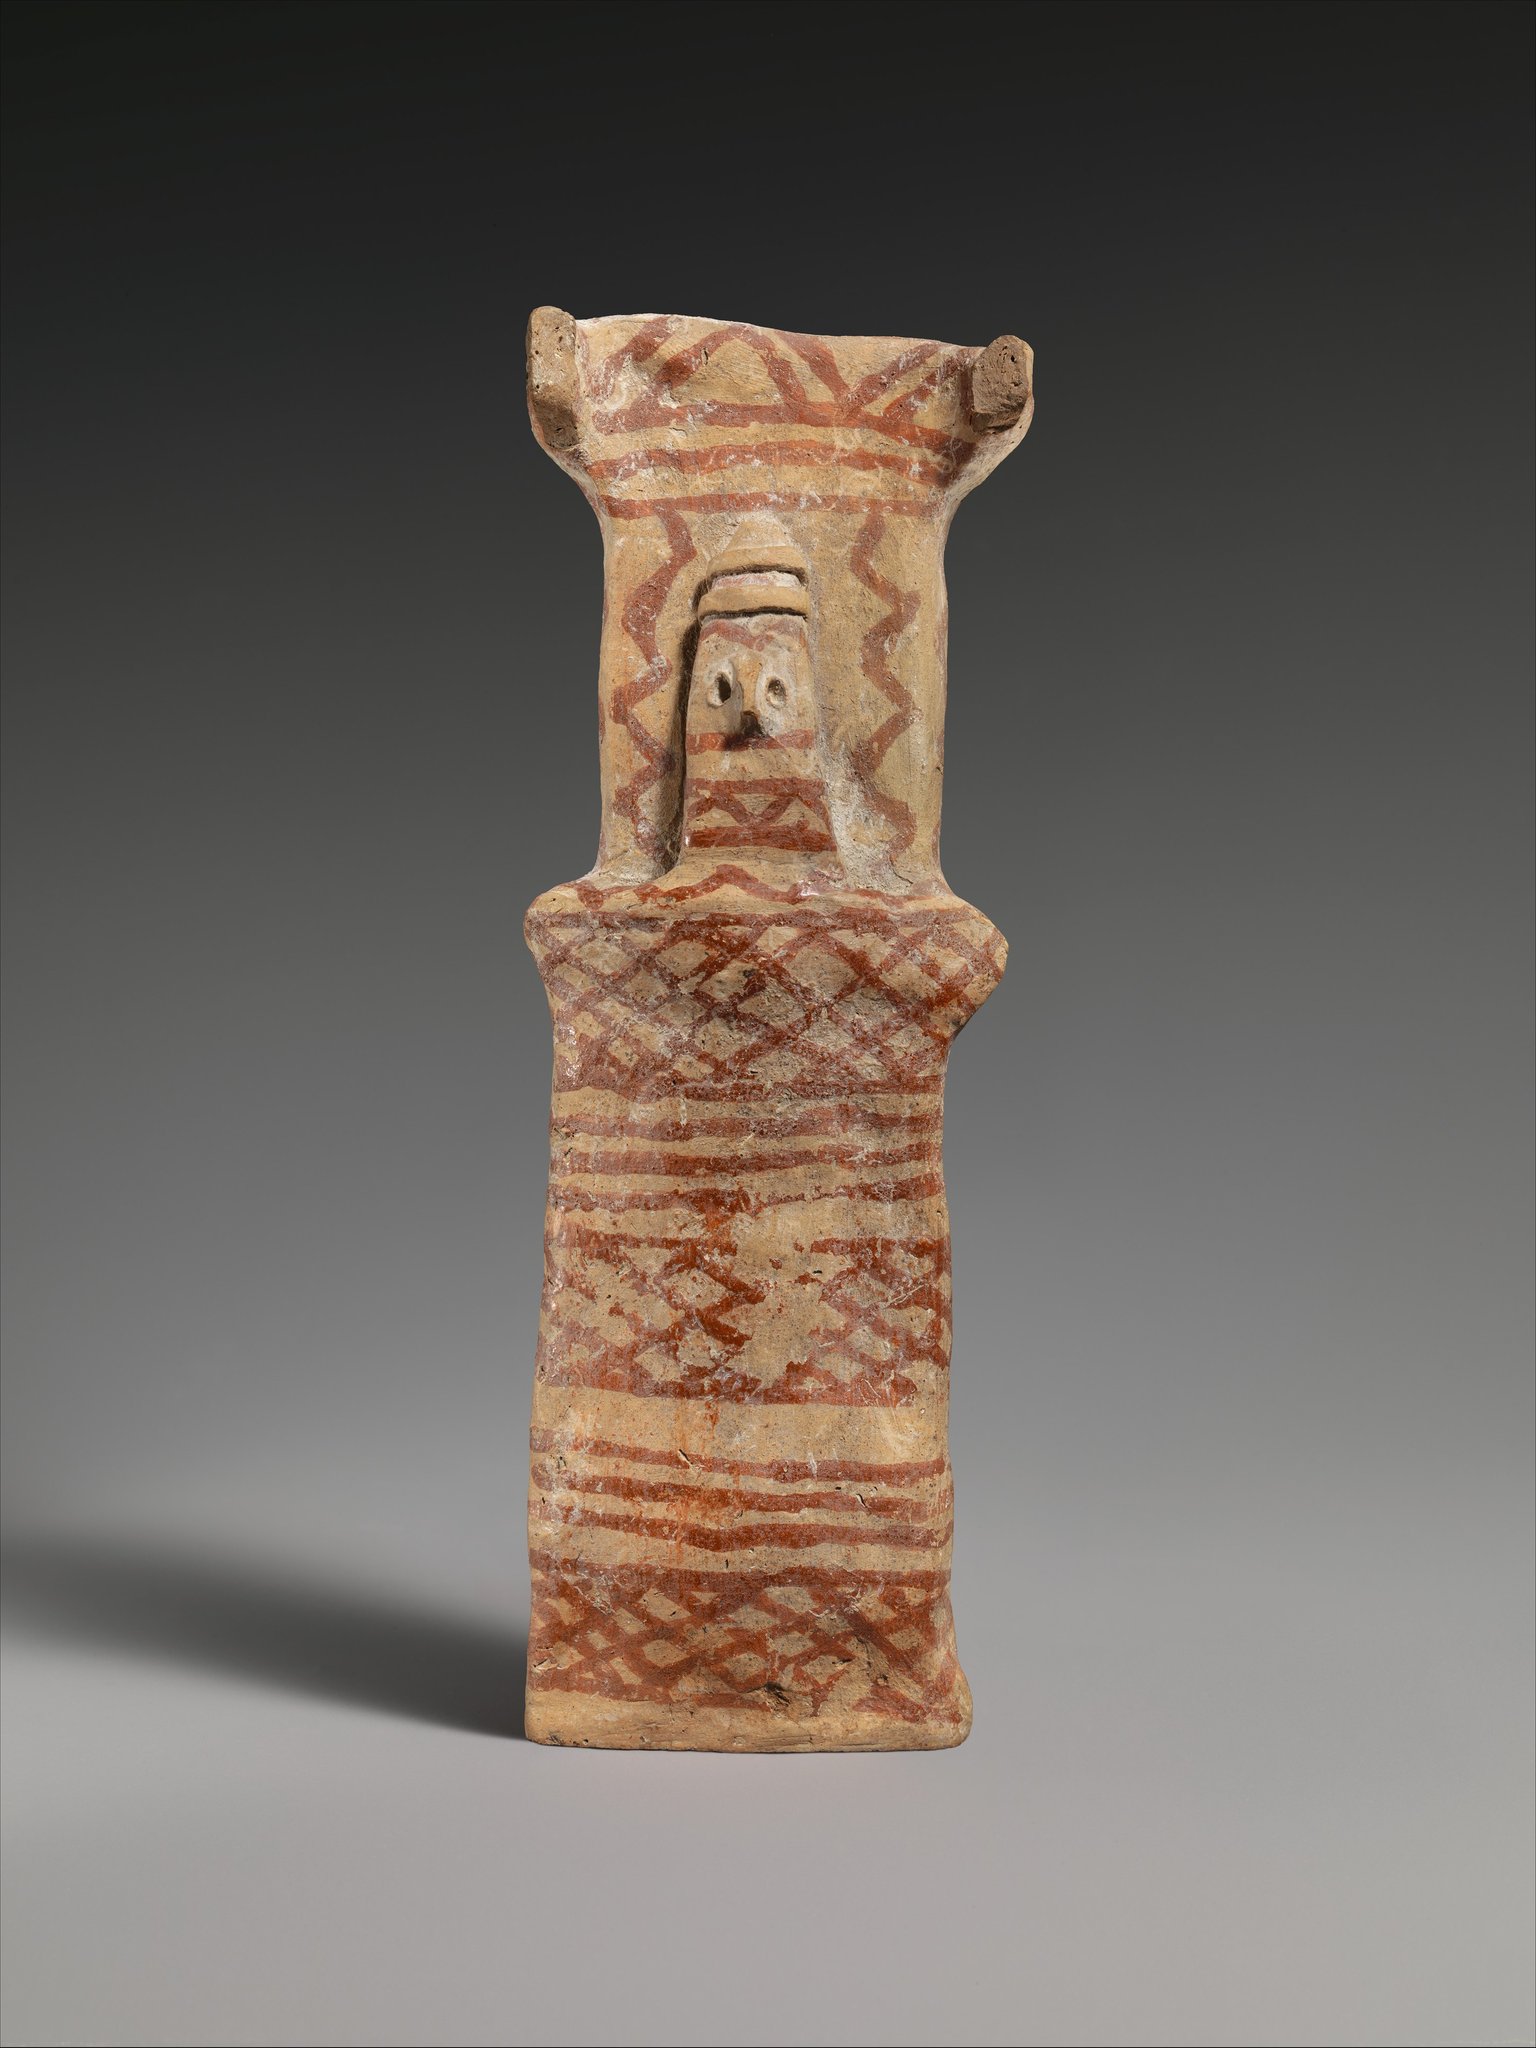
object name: statuette of cradle and infant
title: Terracotta statuette of cradle and infant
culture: cypriot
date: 1900-1600 BCE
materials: terracotta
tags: infants,cradles